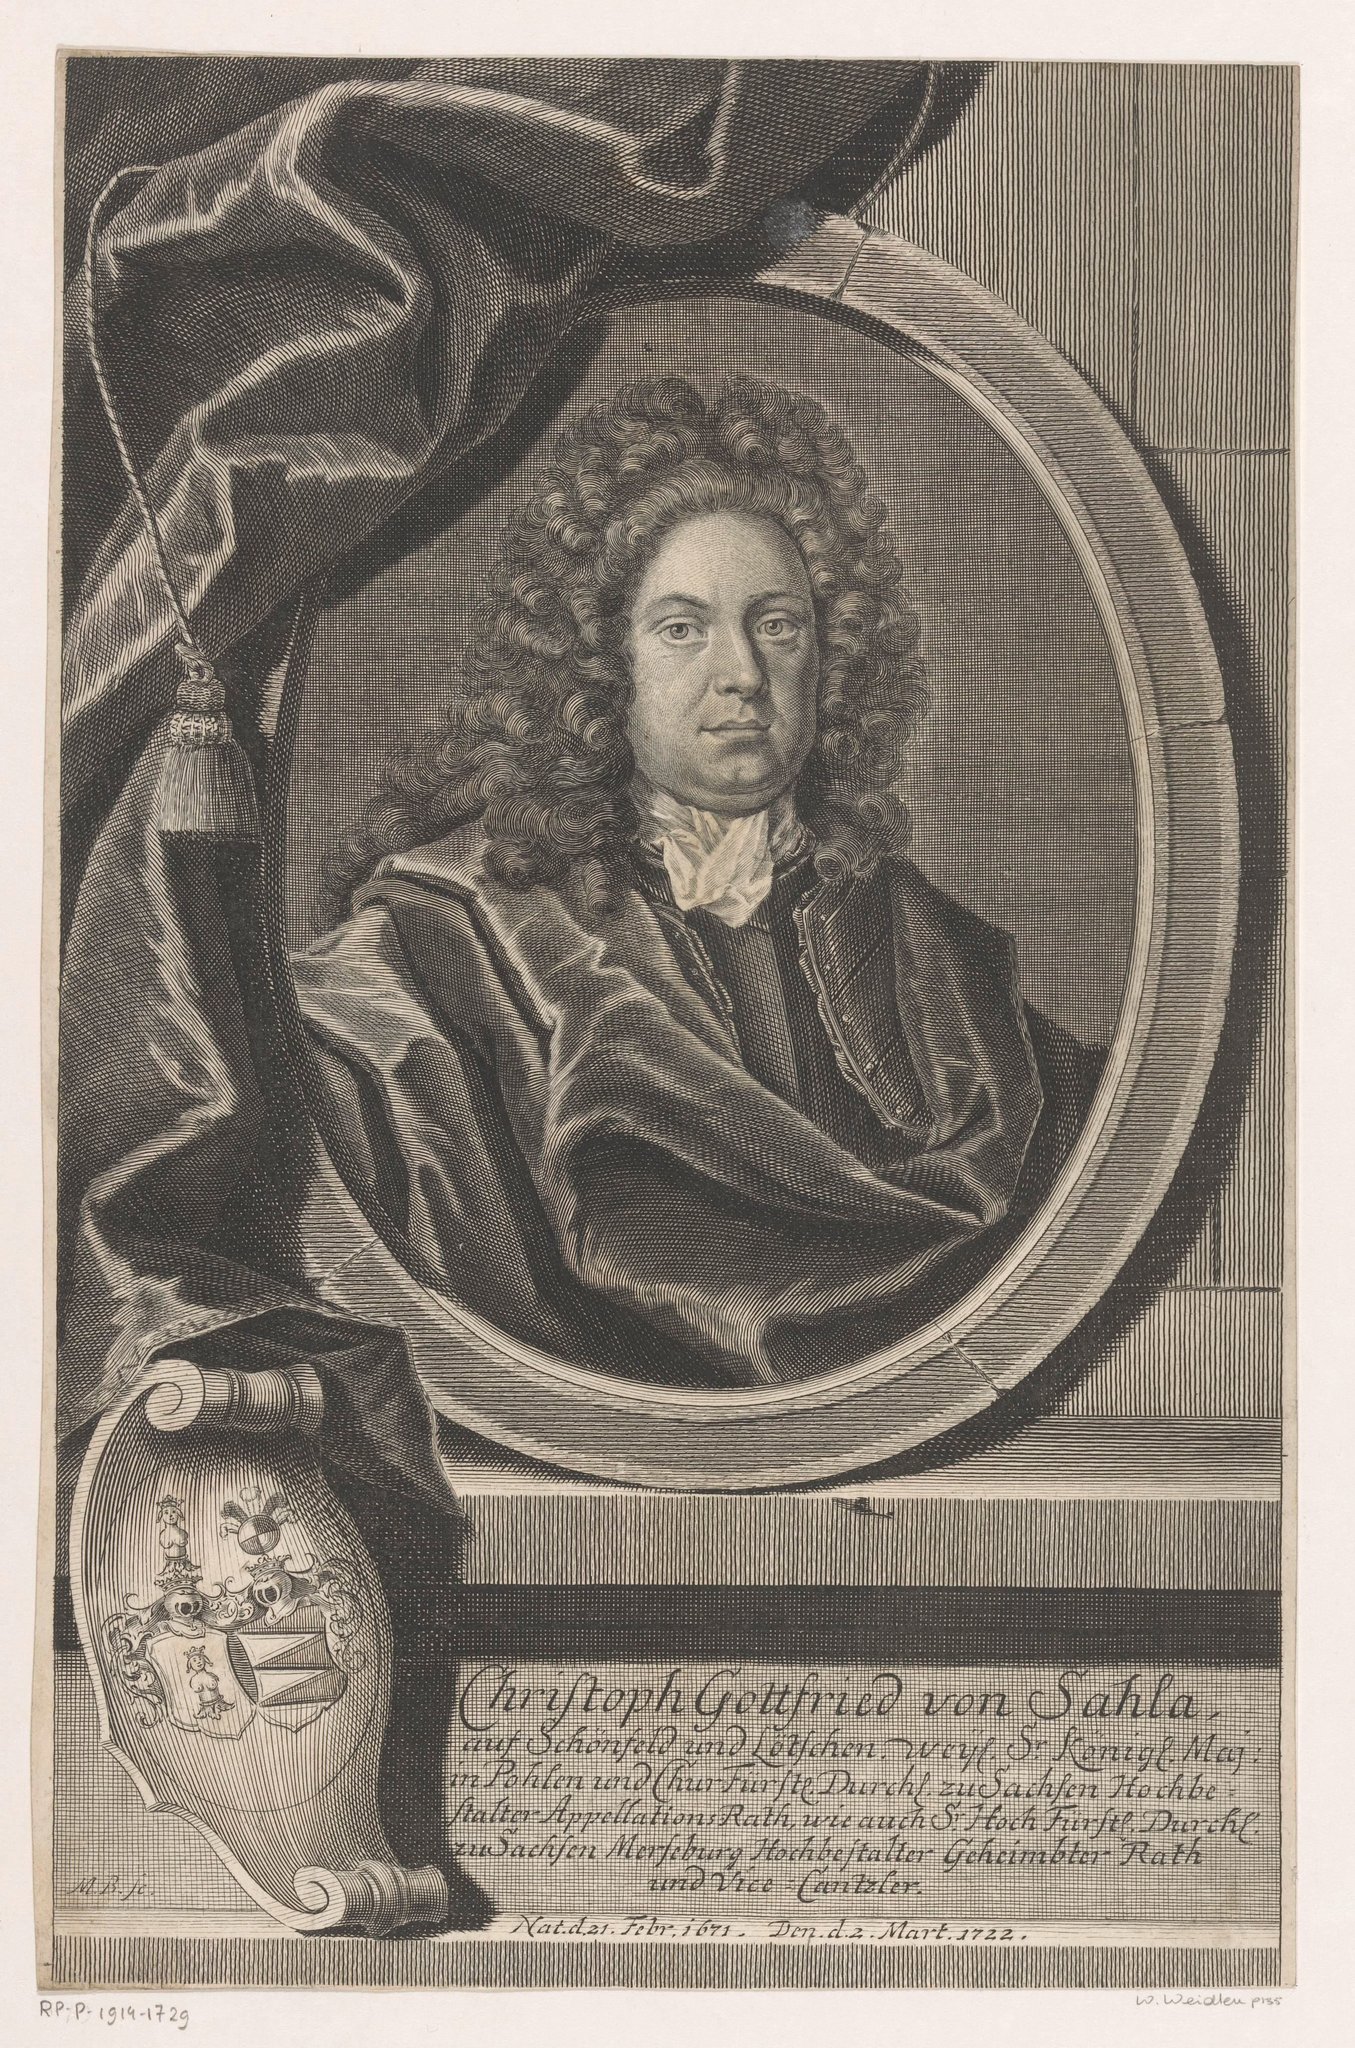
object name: print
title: Portret van Christoph Gottfried von der Sahla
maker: martin bernigeroth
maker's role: print maker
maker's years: 1670-1733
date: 1722-1733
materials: paper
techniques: engraving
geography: leipzig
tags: historical persons, armorial bearing, heraldry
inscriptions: collector's mark: Lugt 2228